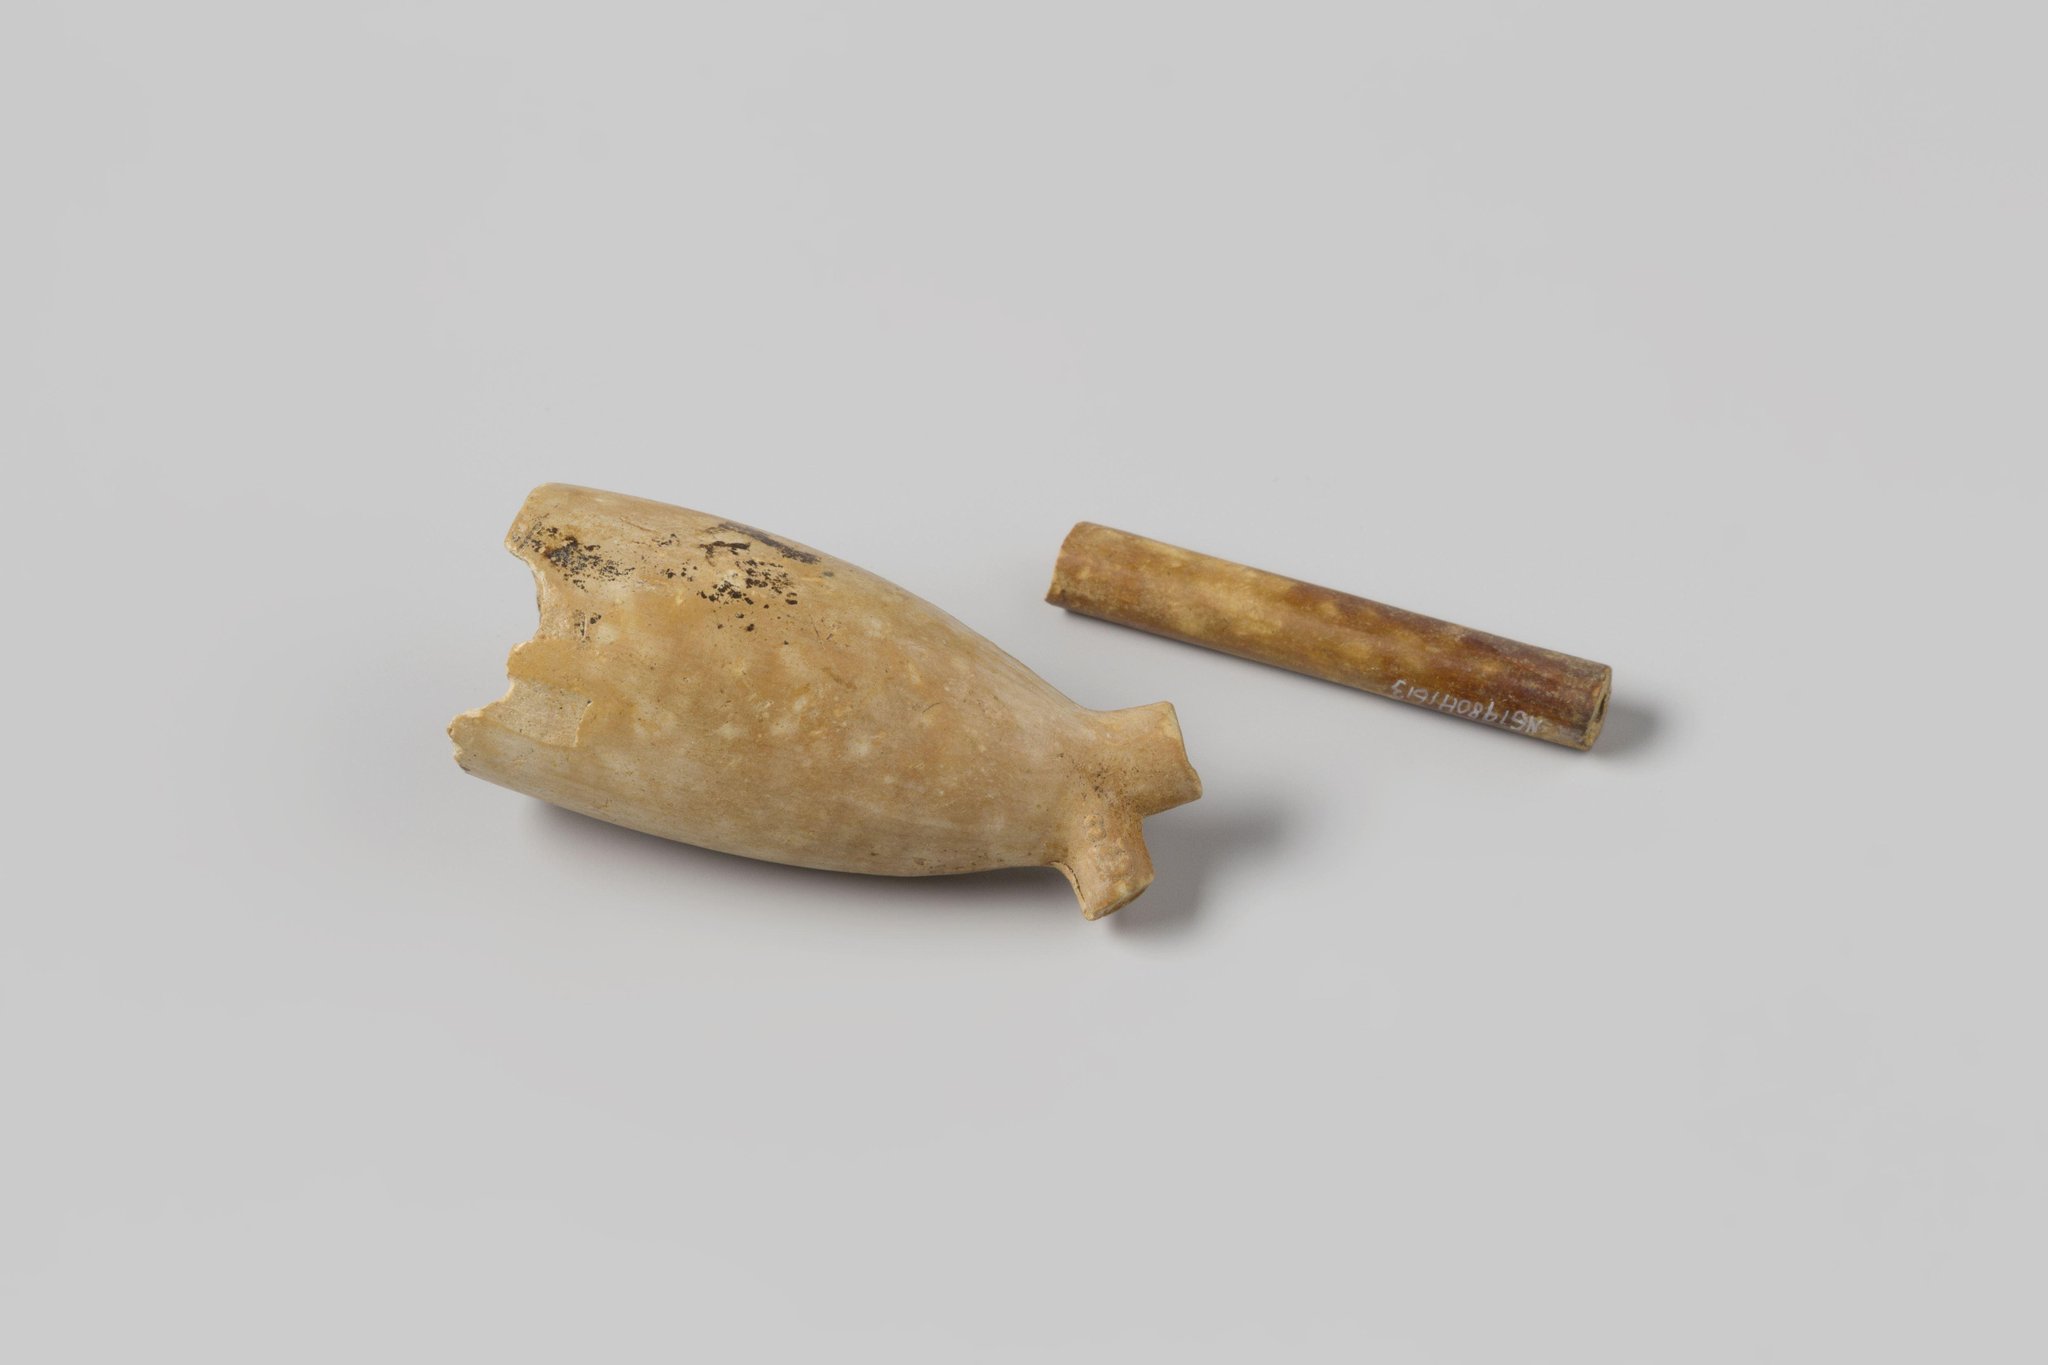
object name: pipe stem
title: Pijpenkop en fragment pijpensteel uit het wrak van de Oost-Indiëvaarder Hollandia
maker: Anonymous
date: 1700-1743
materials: clay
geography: netherlands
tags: verenigde oostindische compagnie, hollandia (schip), annet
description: Pipe, bowl, heelmark: coat of arms of the city of Amsterdam; fragment, 2hsm.